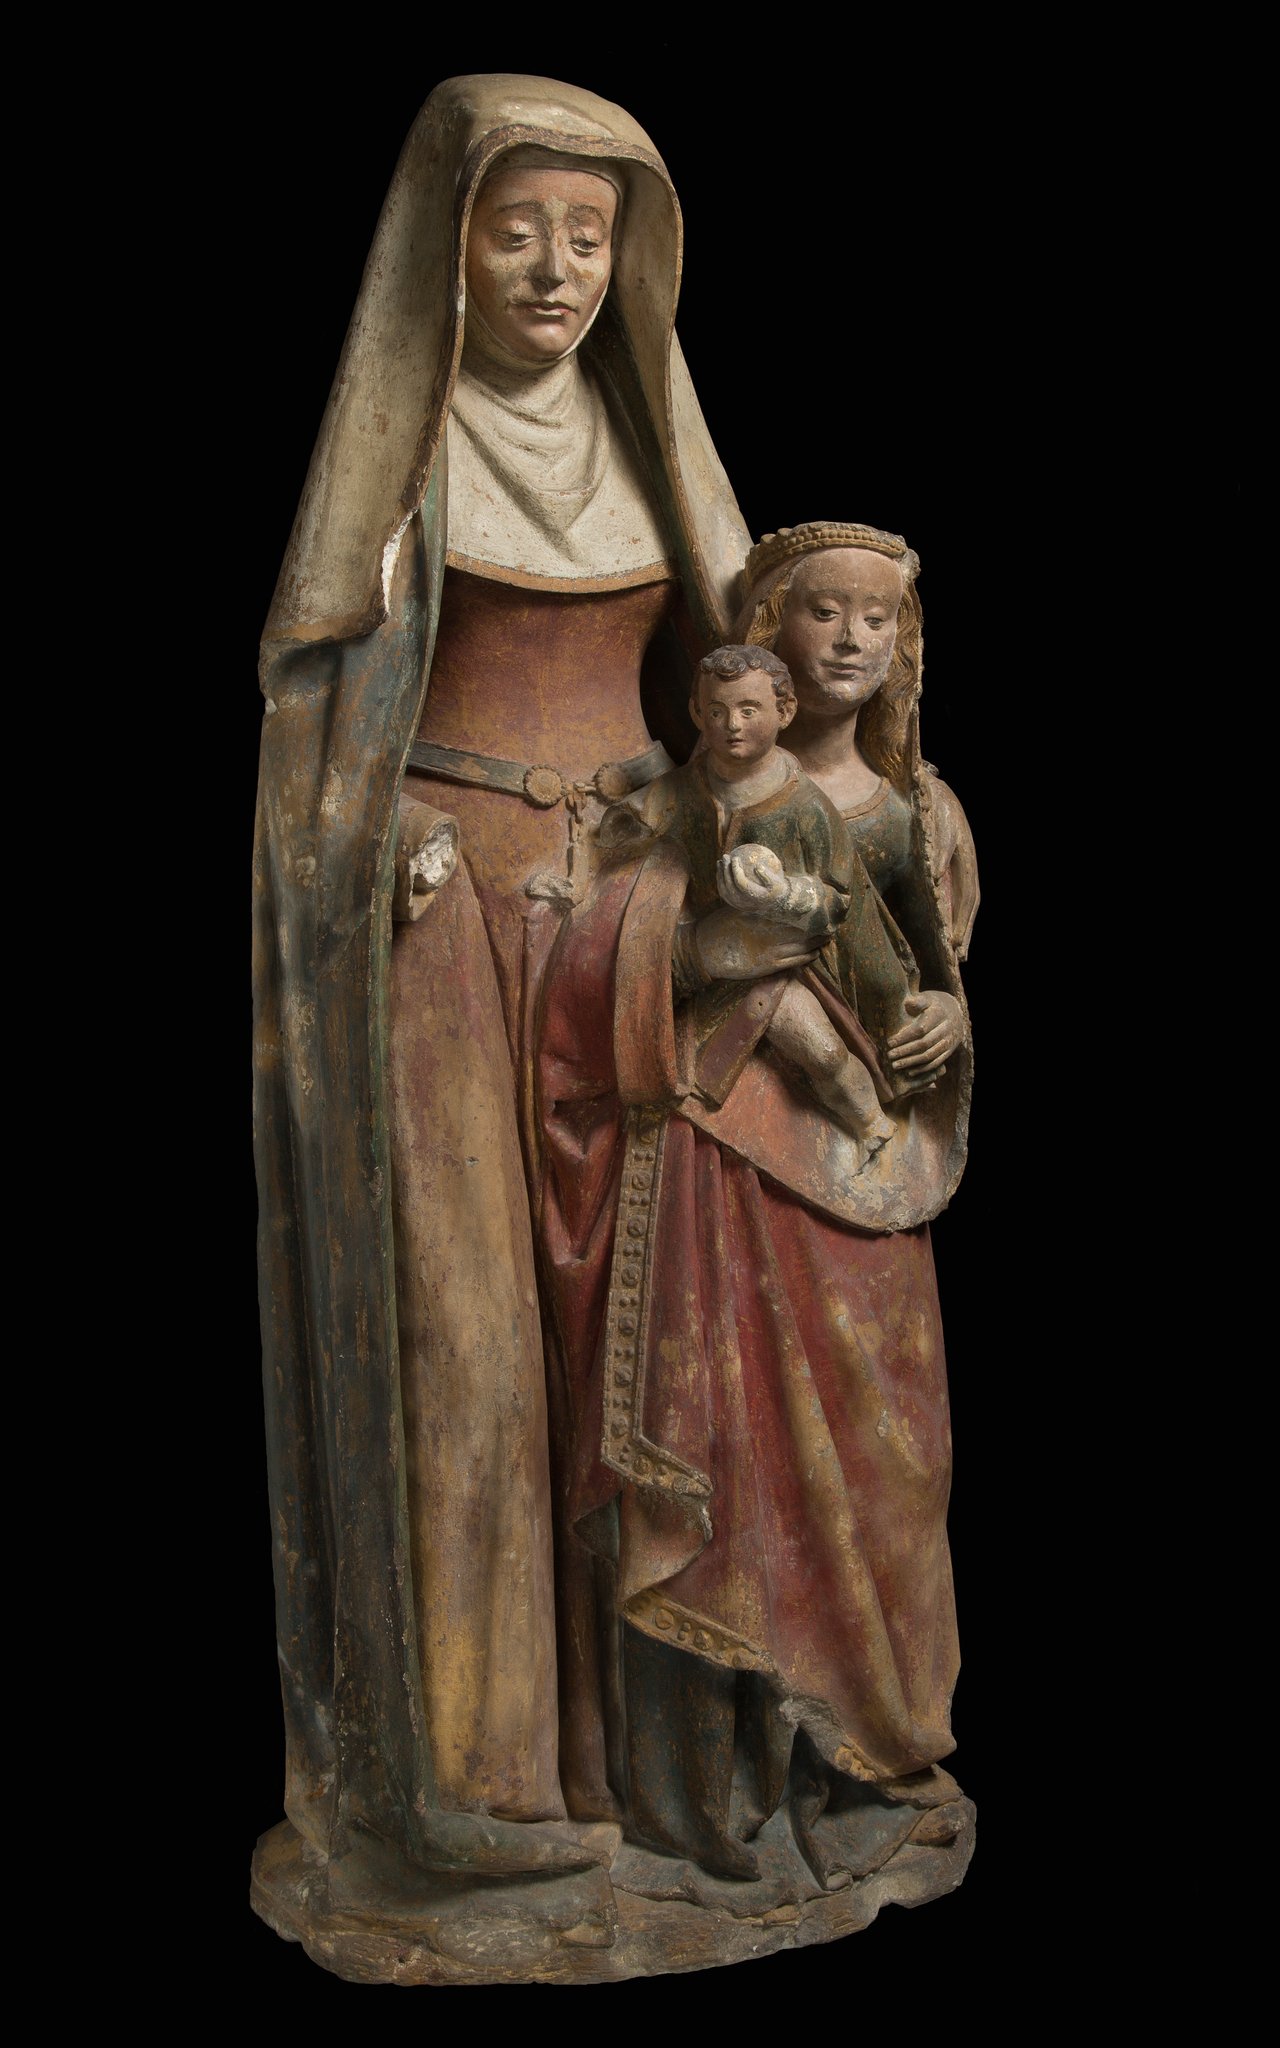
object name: statue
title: Saint Anne with the Virgin and Child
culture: french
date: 1500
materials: limestone, paint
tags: madonna and child,saint anne